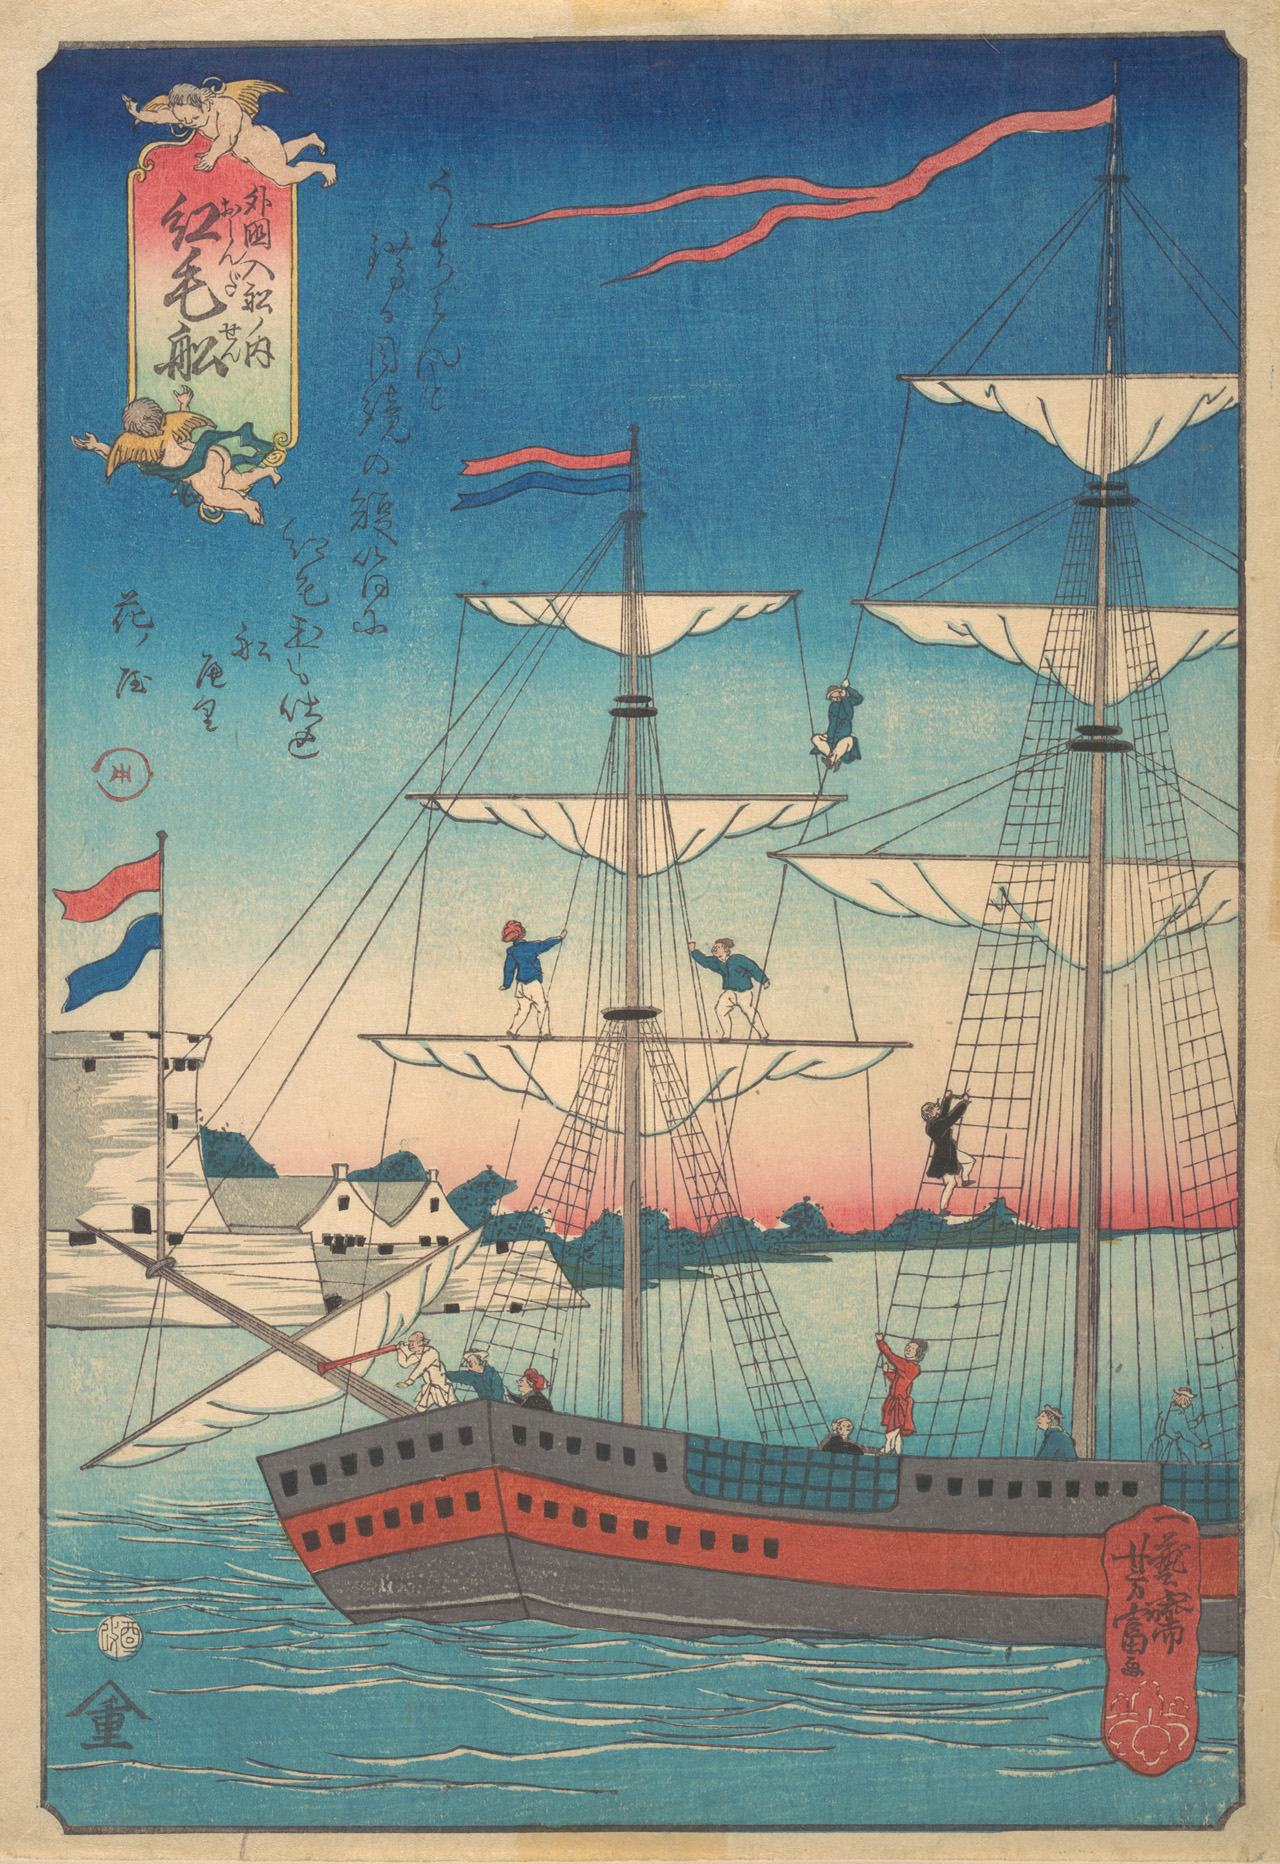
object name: print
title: Dutch Ship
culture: japanese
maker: utagawa yoshitomi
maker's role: artist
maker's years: 1836-1870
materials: ink, paper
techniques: woodblock print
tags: ships